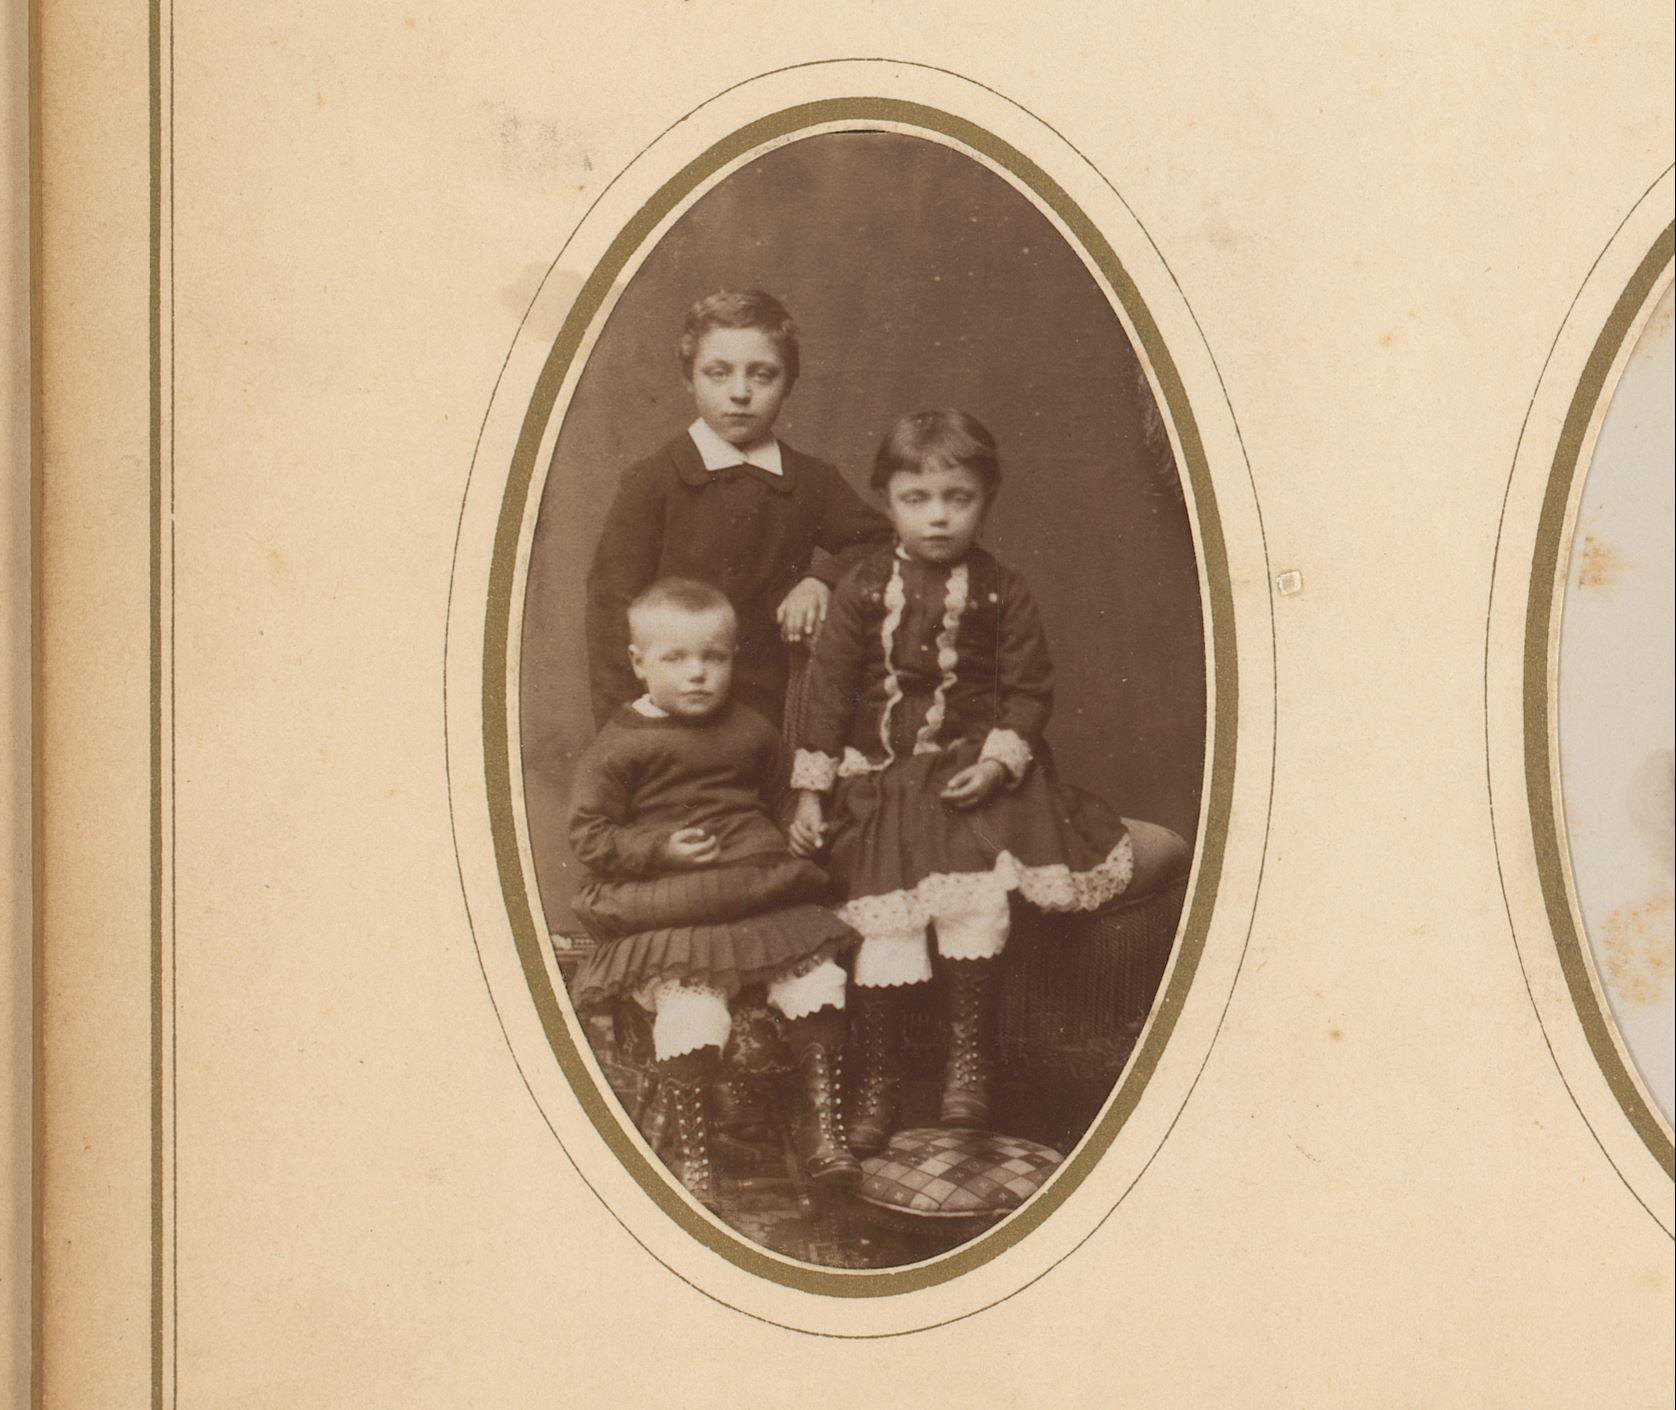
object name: carte de visite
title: Groepsportret van drie kinderen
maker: h.g. de groot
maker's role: printer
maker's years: 1860-1909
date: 1870-1900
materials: cardboard, photographic support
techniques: albumen print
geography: leeuwarden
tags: child between toddler and youth (of undetermined sex) (+ two persons), tot, toddler ~ the ages of man, anonymous historical persons portrayed in a group, in a group-portrait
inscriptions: inscription: ‘Photografi/ van/ H. G. de Groot Hzn./ Hofplein/ hoek St.Jacobstraat/ Leeuwarden’